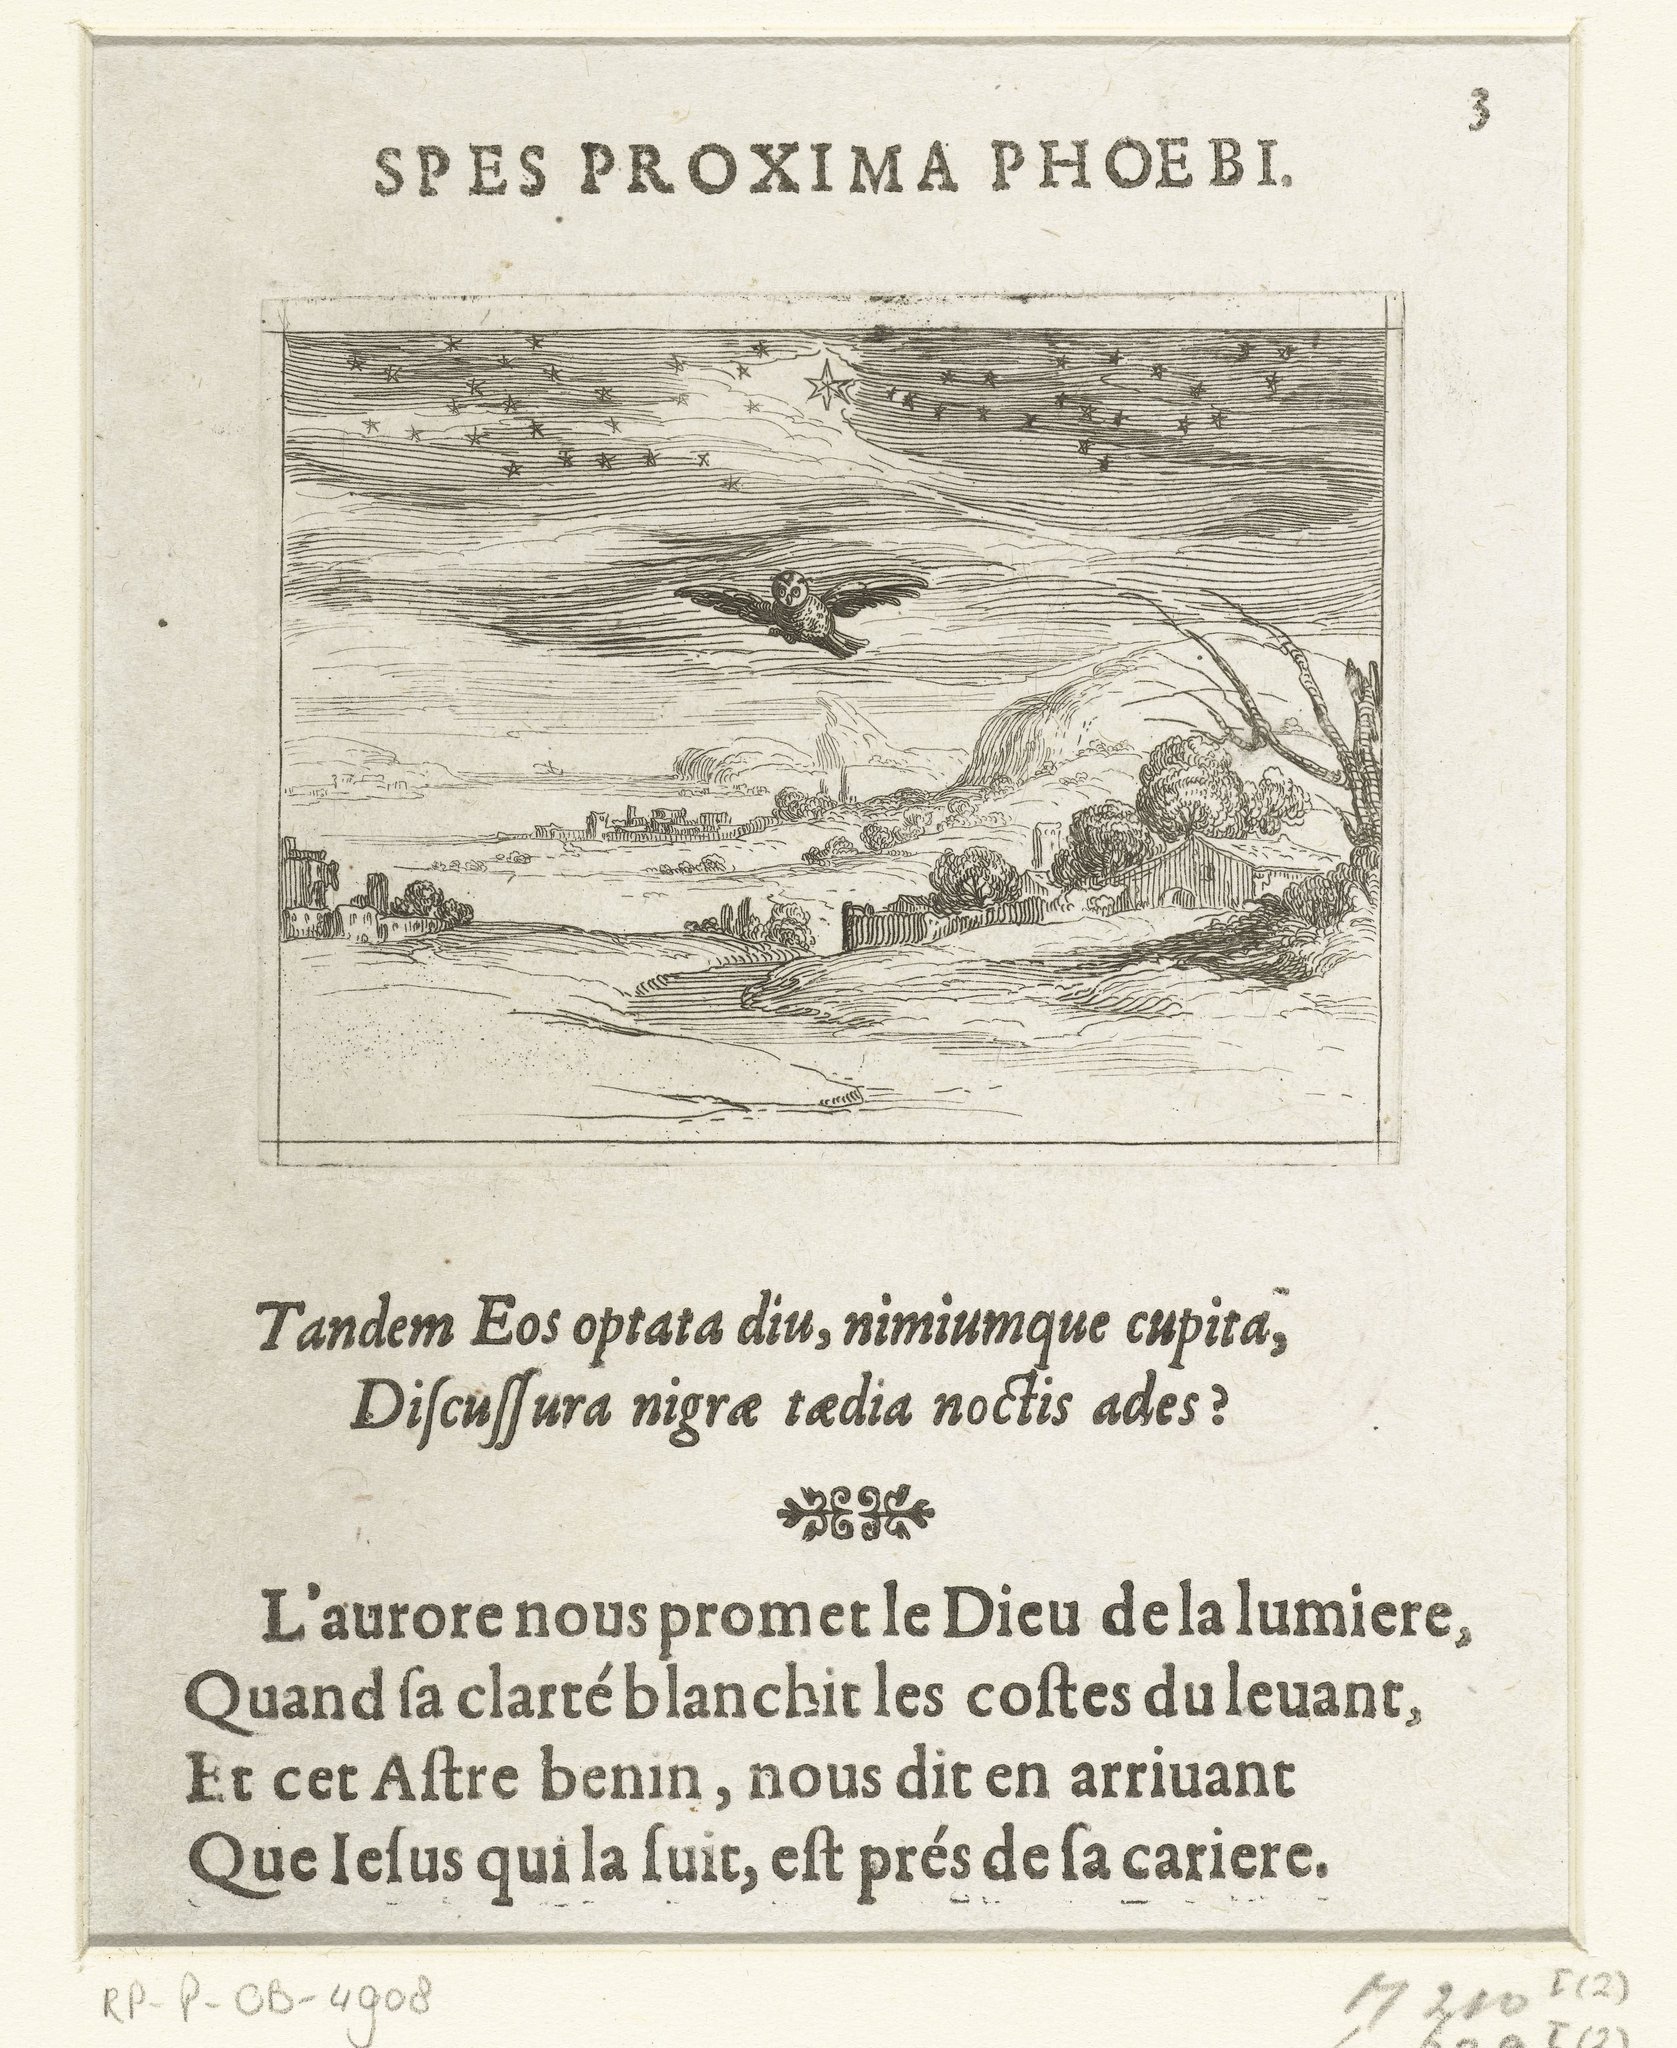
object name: cognizance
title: Leven van Maria in emblemen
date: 1625-1629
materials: paper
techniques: etching, letterpress printing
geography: france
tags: morning ~ landscape (sometimes titled 'aurora')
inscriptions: collector's mark: Lugt 240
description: Voorstelling van het aanbreken van de dag boven een landschap met huisjes. Sterren verdwijnen, een uil vliegt weg, de lucht wordt in de verte lichter. Boven en onder deze prent Latijnse en Franse teksten in boekdruk. Dit blad is onderdeel van de embleemserie 'Leven van Maria in emblemen'. De eerste staat van deze serie behelst naast een titelpagina en 26 emblemen ook drie bladen met lofzangen op Maria in boekdruk zonder afbeelding.